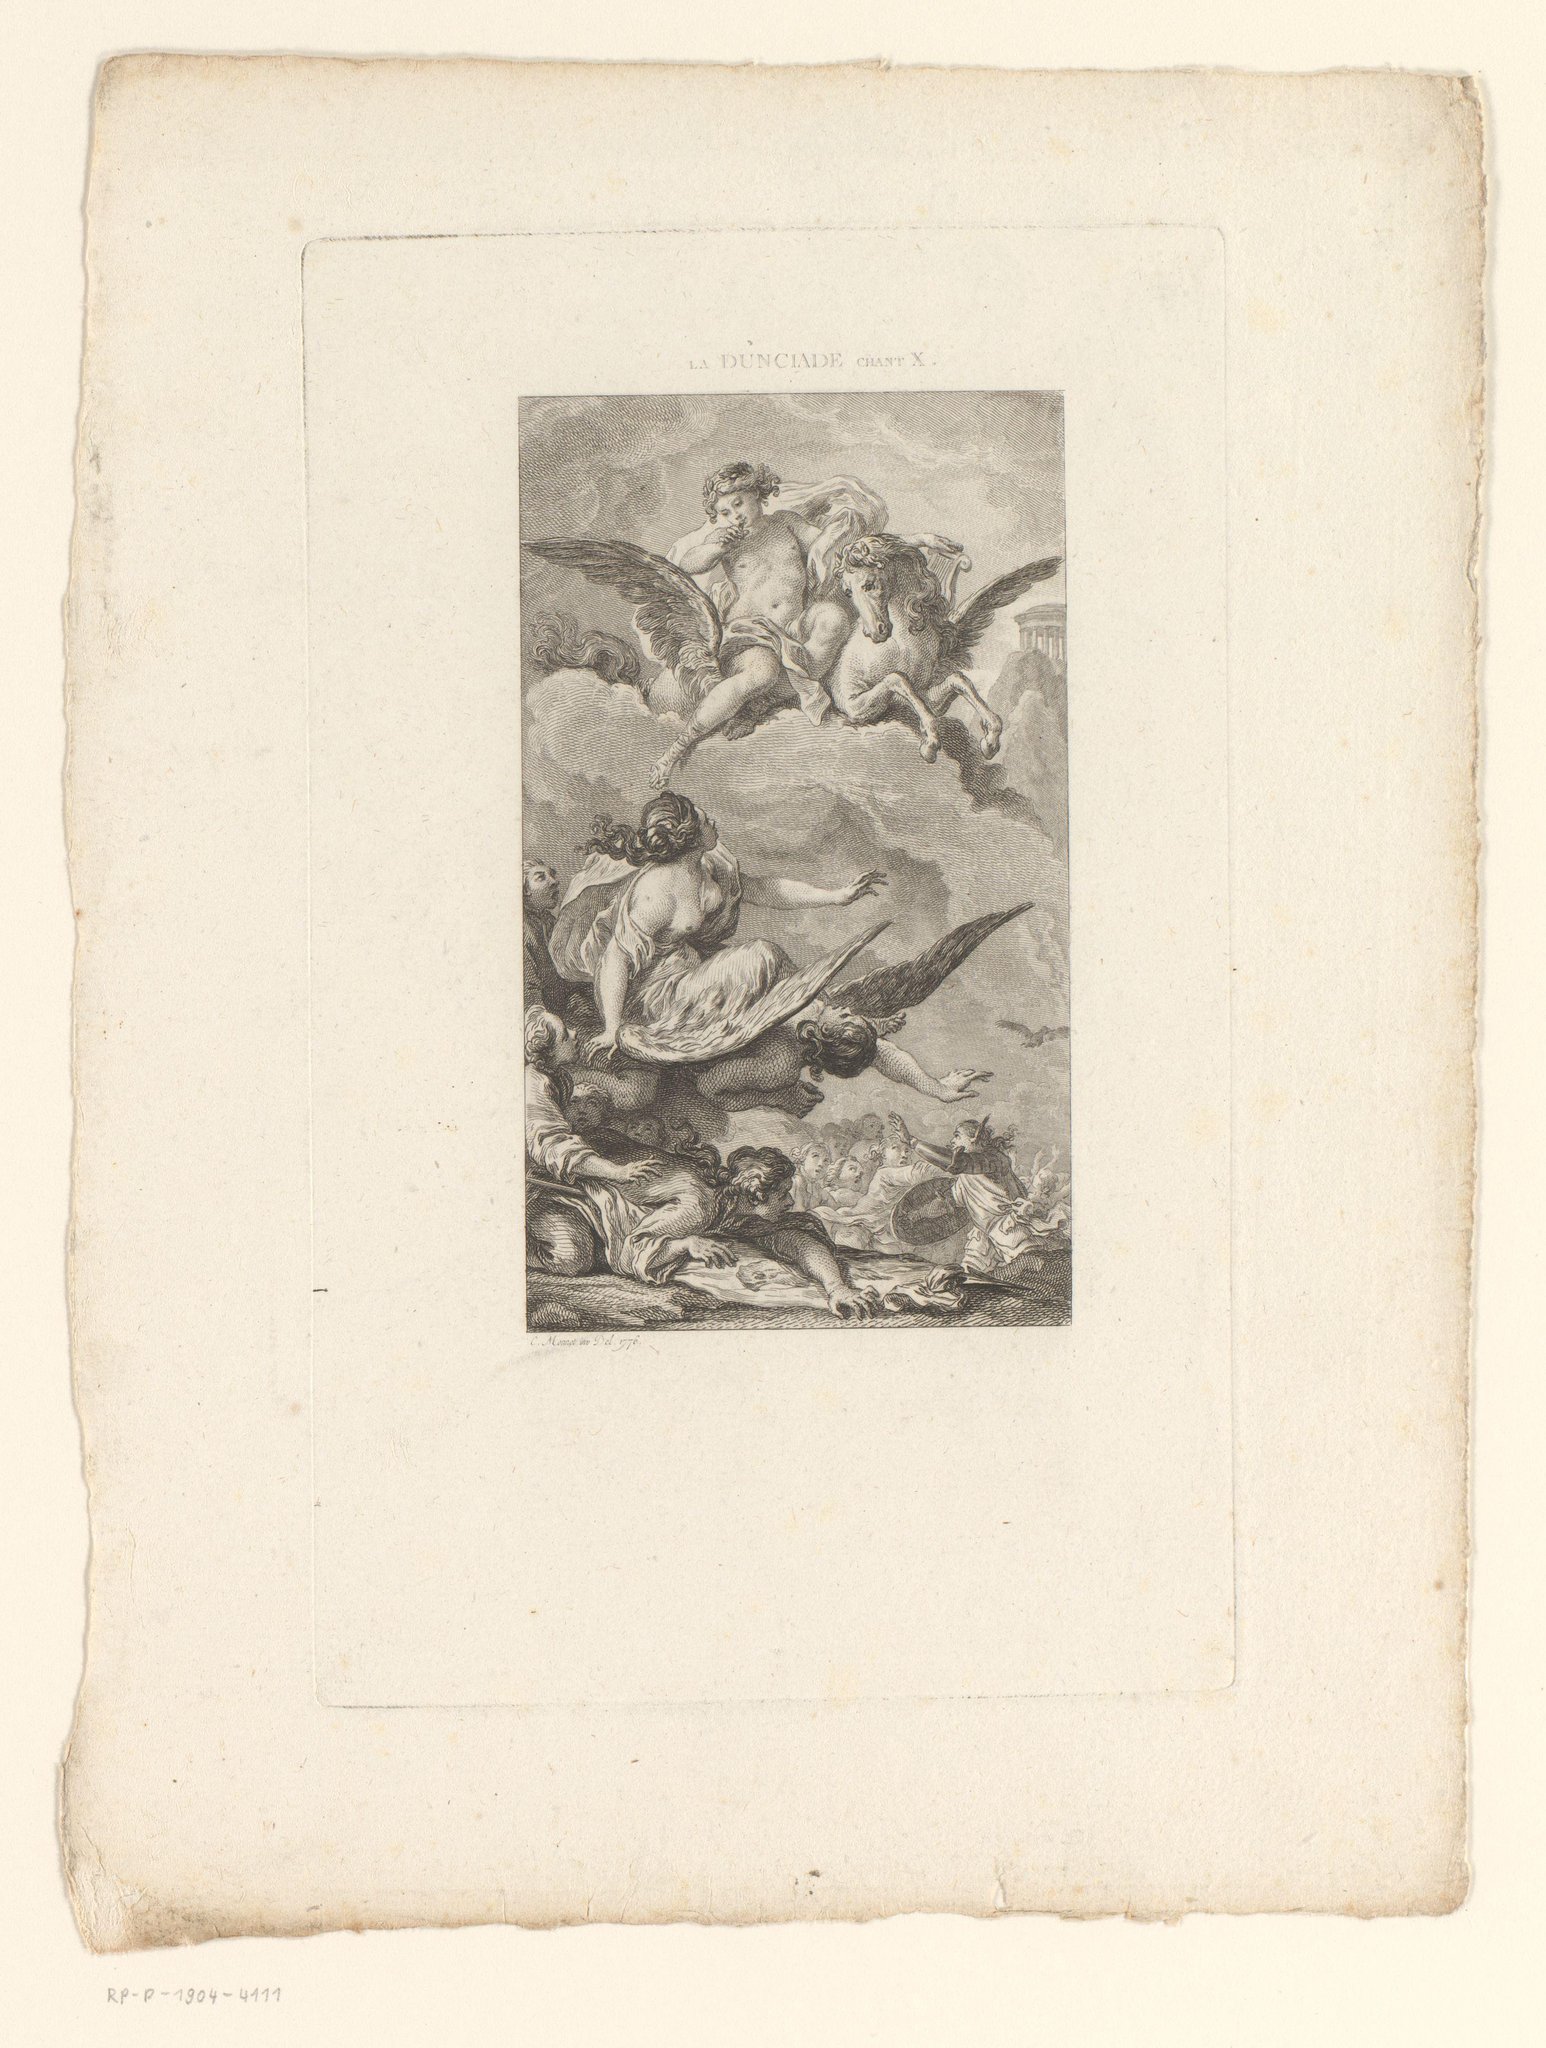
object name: print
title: Scène uit een gedicht met Pegasus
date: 1776-1800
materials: paper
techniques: engraving, etching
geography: france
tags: pegasus, the winged horse, literary characters and objects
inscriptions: collector's mark: Lugt 2228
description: Prent uit: Palissot de Montenoy, Ch. La dunciade, poeme en dix chants. Parijs en Londen: s.n.s.a.